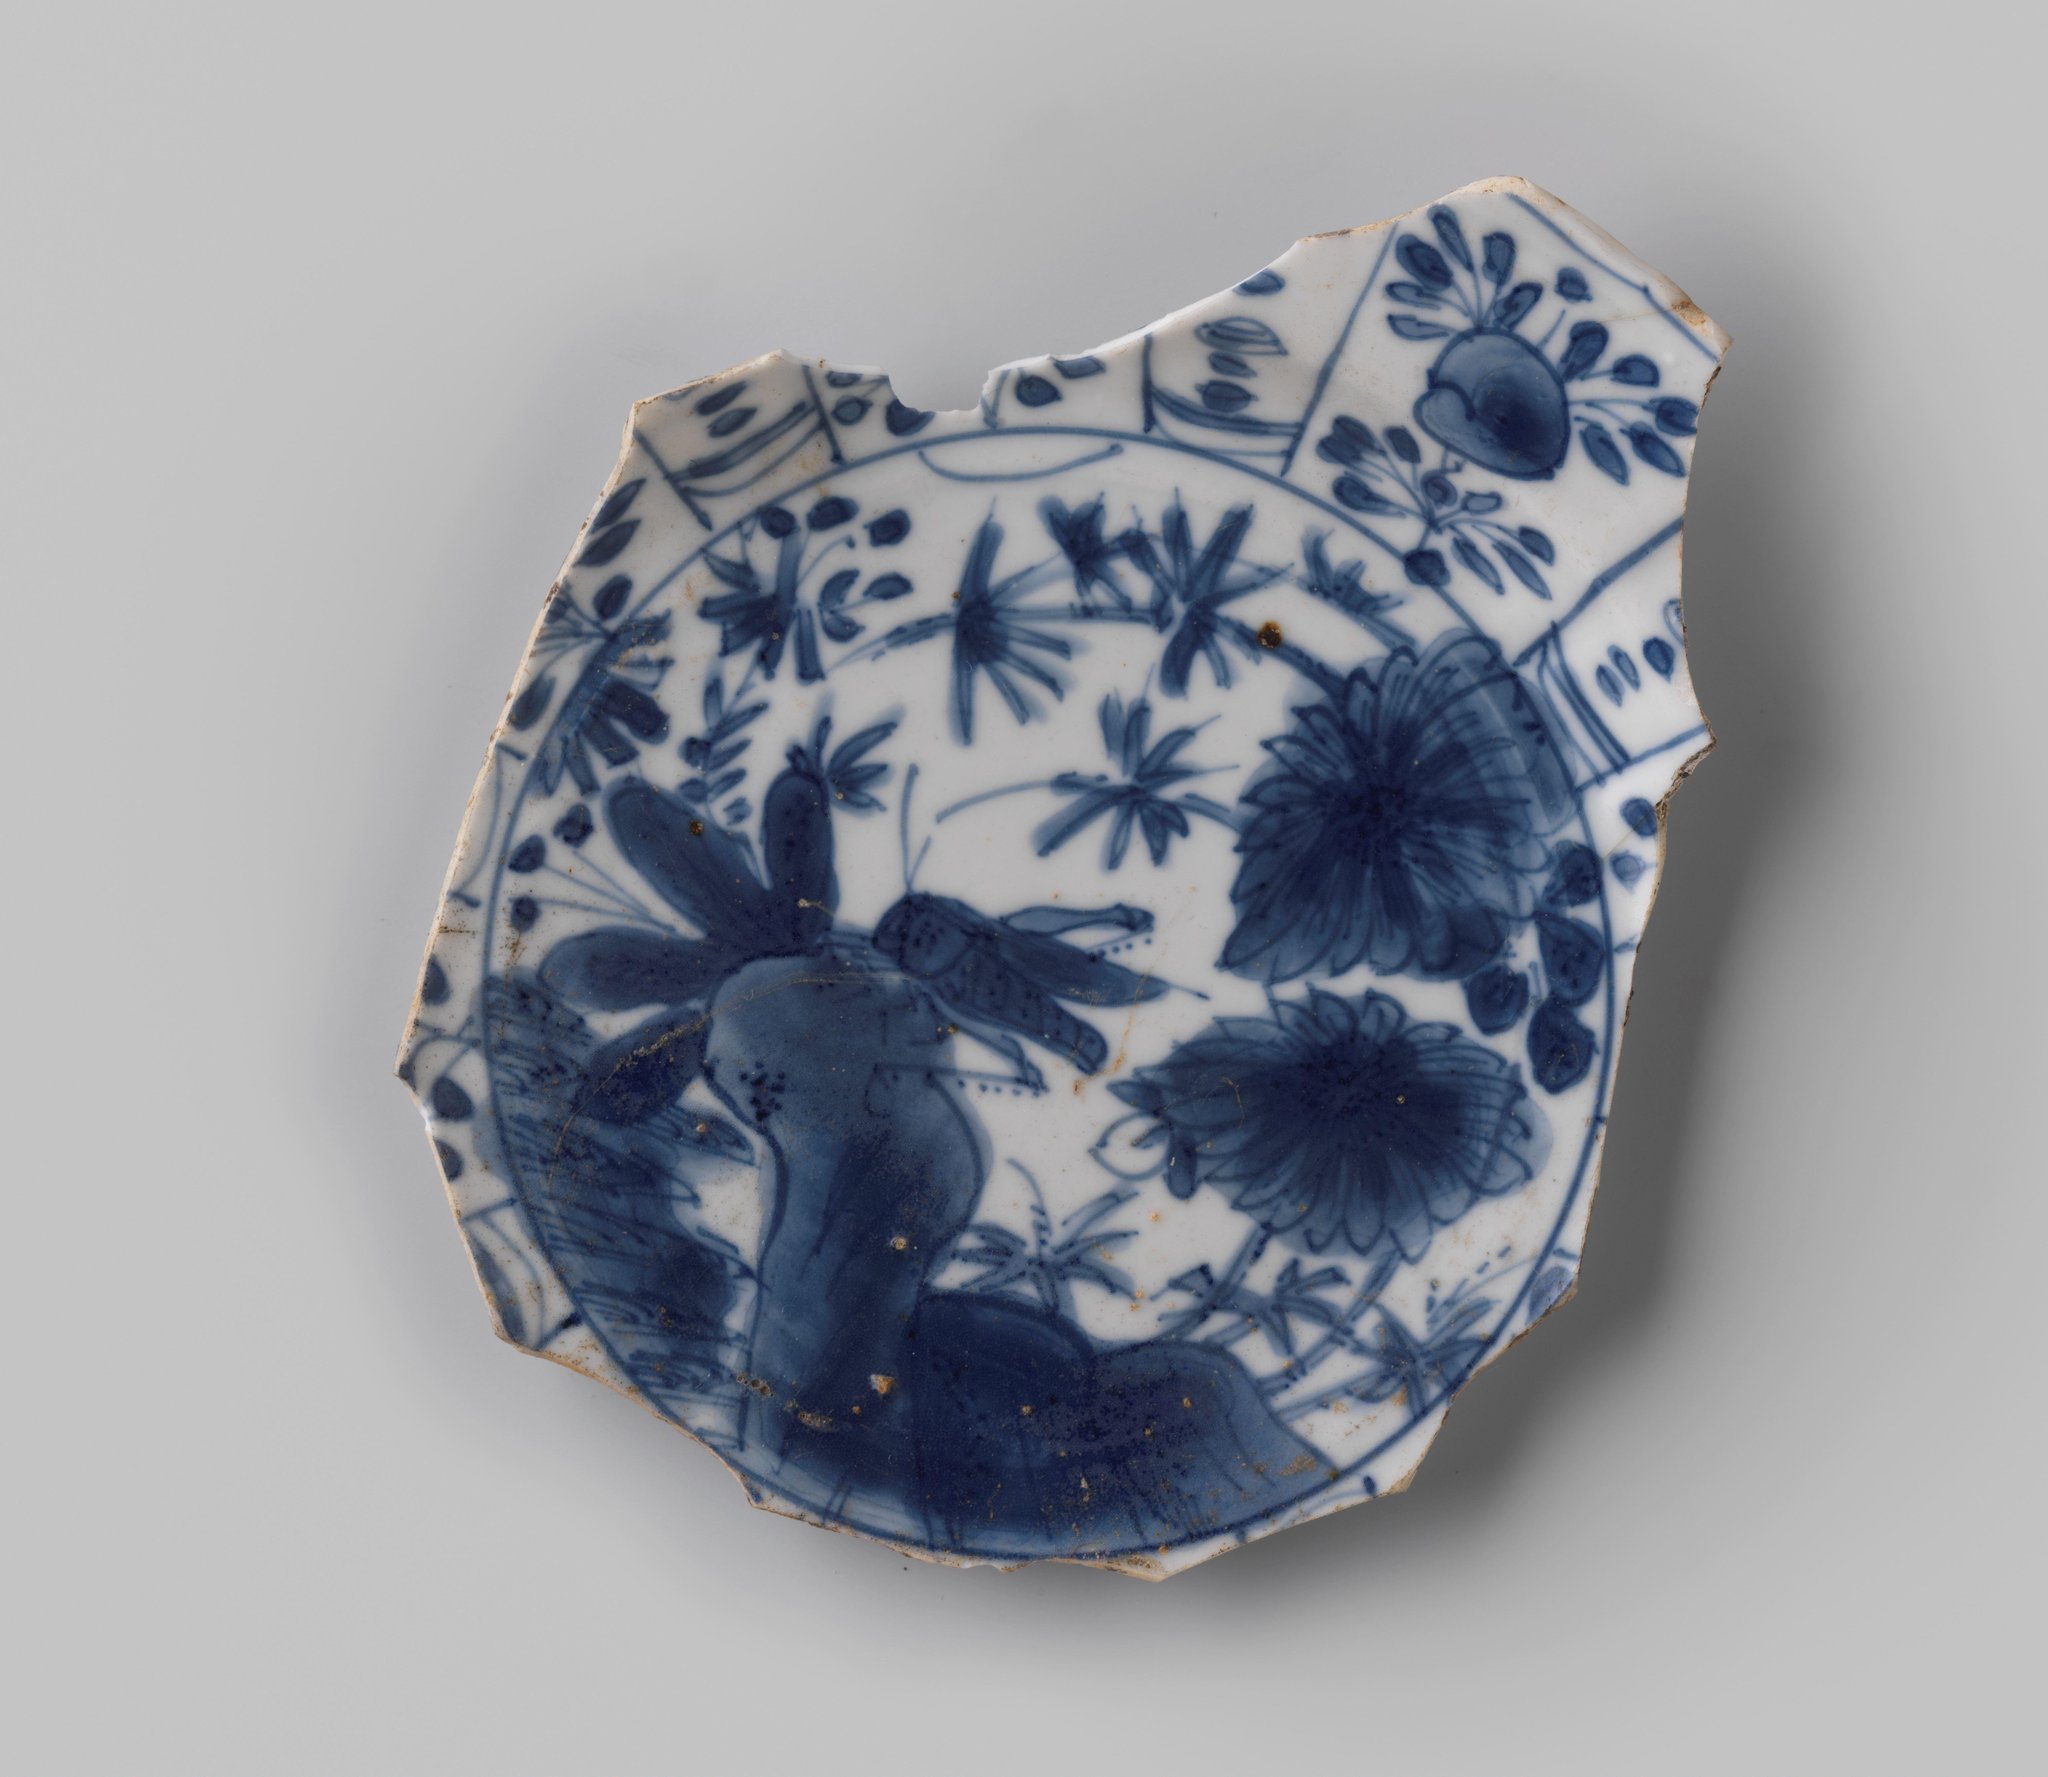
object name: plate dish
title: Fragment bord uit V.O.C.-schip de 'Witte Leeuw'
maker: Anonymous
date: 1613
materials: bone china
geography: jingdezhen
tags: verenigde oostindische compagnie, sint-helena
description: A saucer with a flattened rim. A saucer with a flattened rim. A central decoration of a grasshopper on a rock and a chrysanthemum. Panels decorated with peaches and flowers.